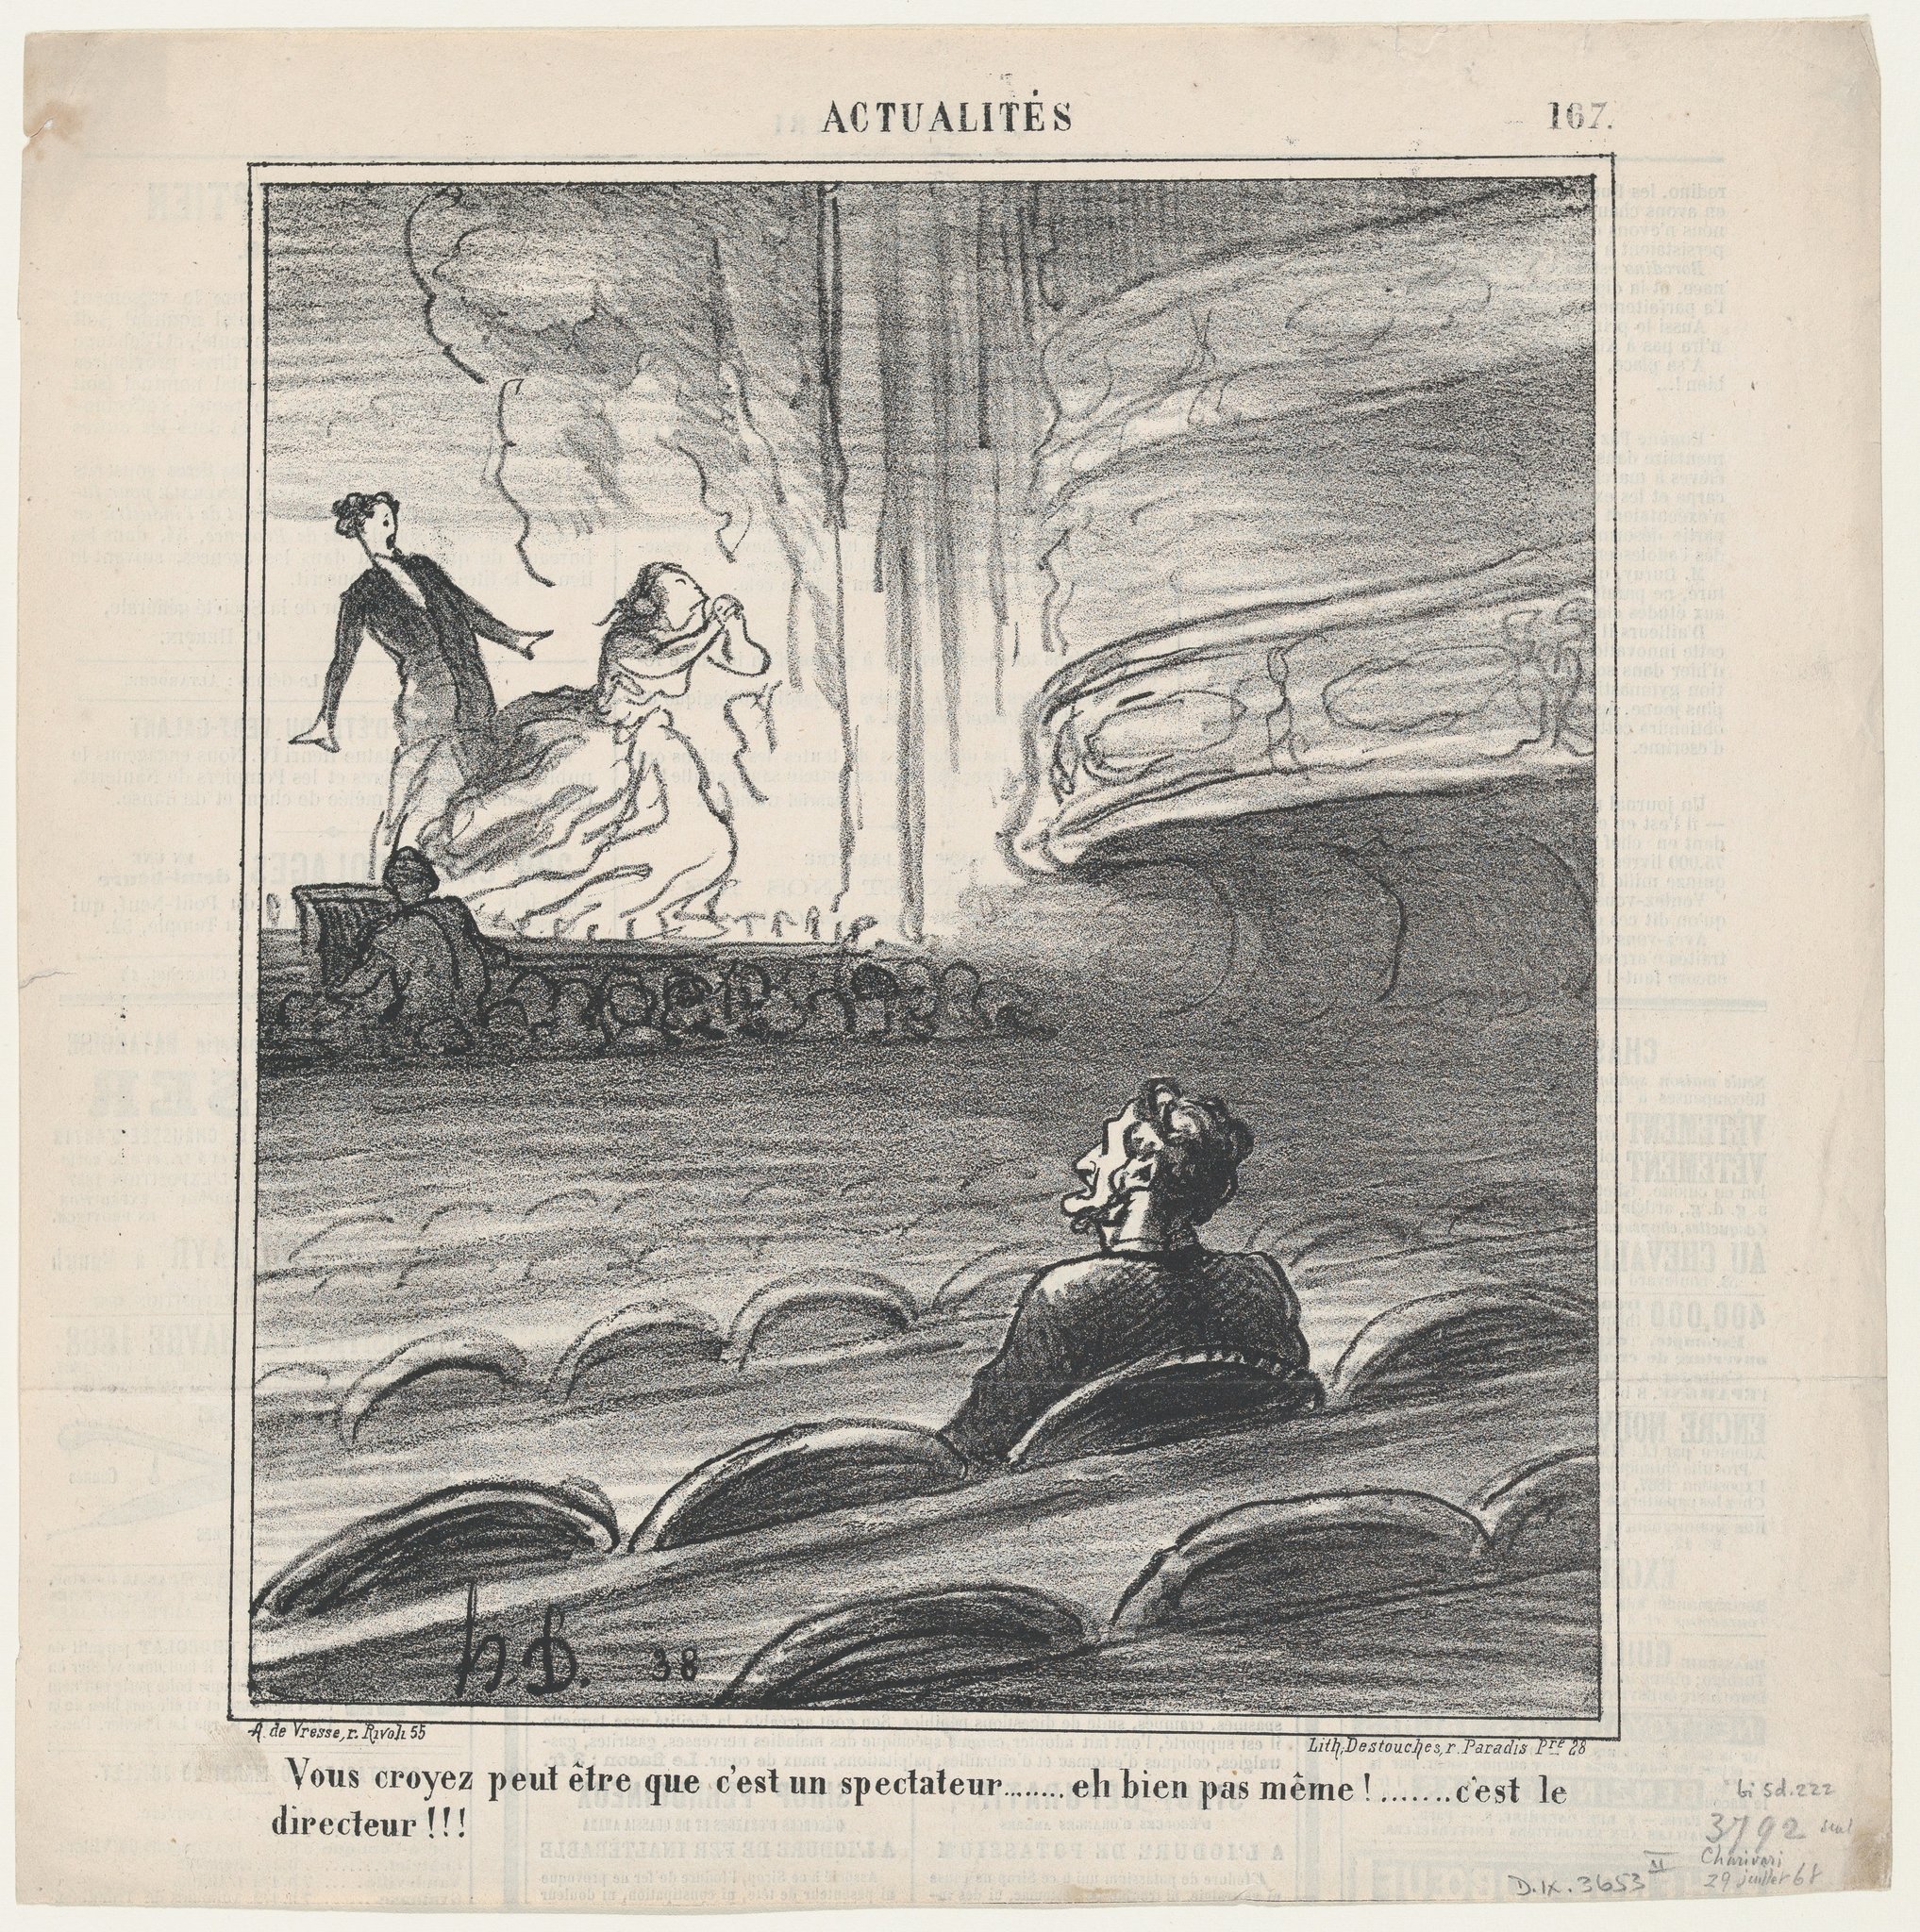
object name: print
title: You may suspect that this is a spectator! But you are wrong.... It's the manager of the theater!, from 'News of the day,' published in Le Charivari, July 29, 1868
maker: honoré daumier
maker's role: artist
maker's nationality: french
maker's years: 1808-1879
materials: paper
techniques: lithograph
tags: satire,theatre,men,women,spectators,actors